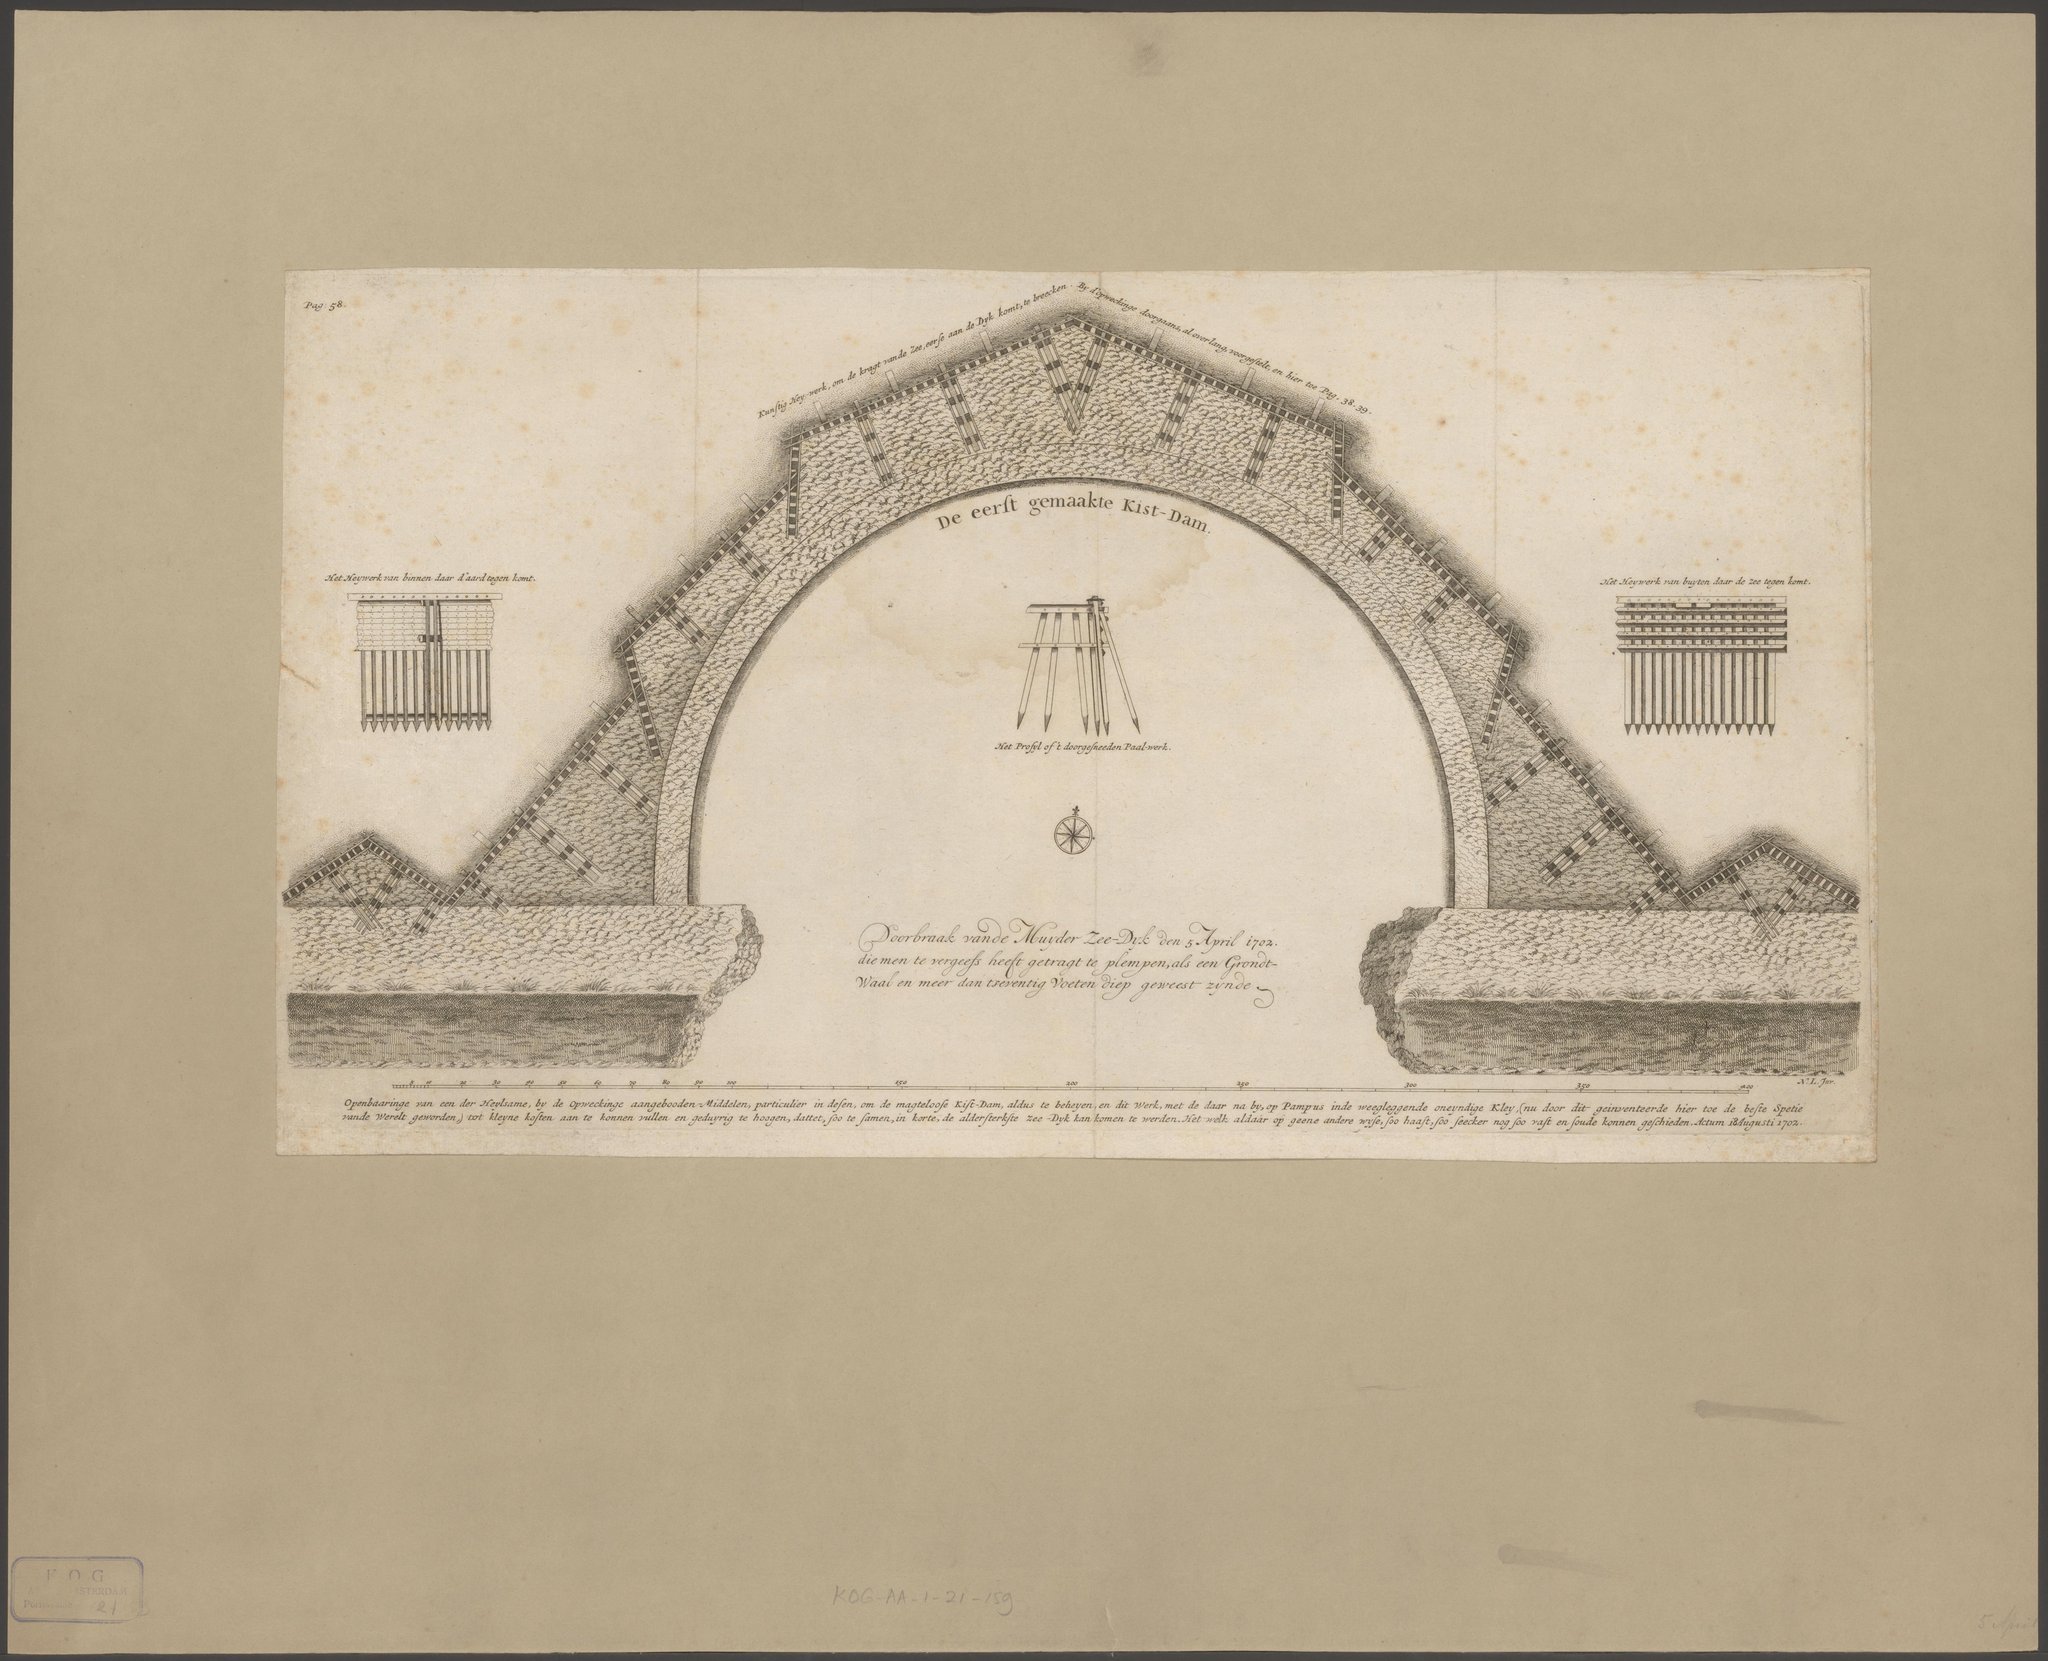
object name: print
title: Ontwerp voor de eerste kistdam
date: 1702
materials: paper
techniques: engraving, etching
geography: amsterdam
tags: dikes, levee, amsterdam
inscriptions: collector's mark: Lugt 1641b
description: Prent waarschijnlijk uit: Listingh, Nicolaas. Incitamentum & adiumentum. Dat is opweckinge ende aanleydinge, tot het uytvinden van bequaame middelen en gronden om de zee-dycken (…) te beschermen en te bevreyden. Amsterdam: erven Paulus Matthijsz, 1702, p. 58.